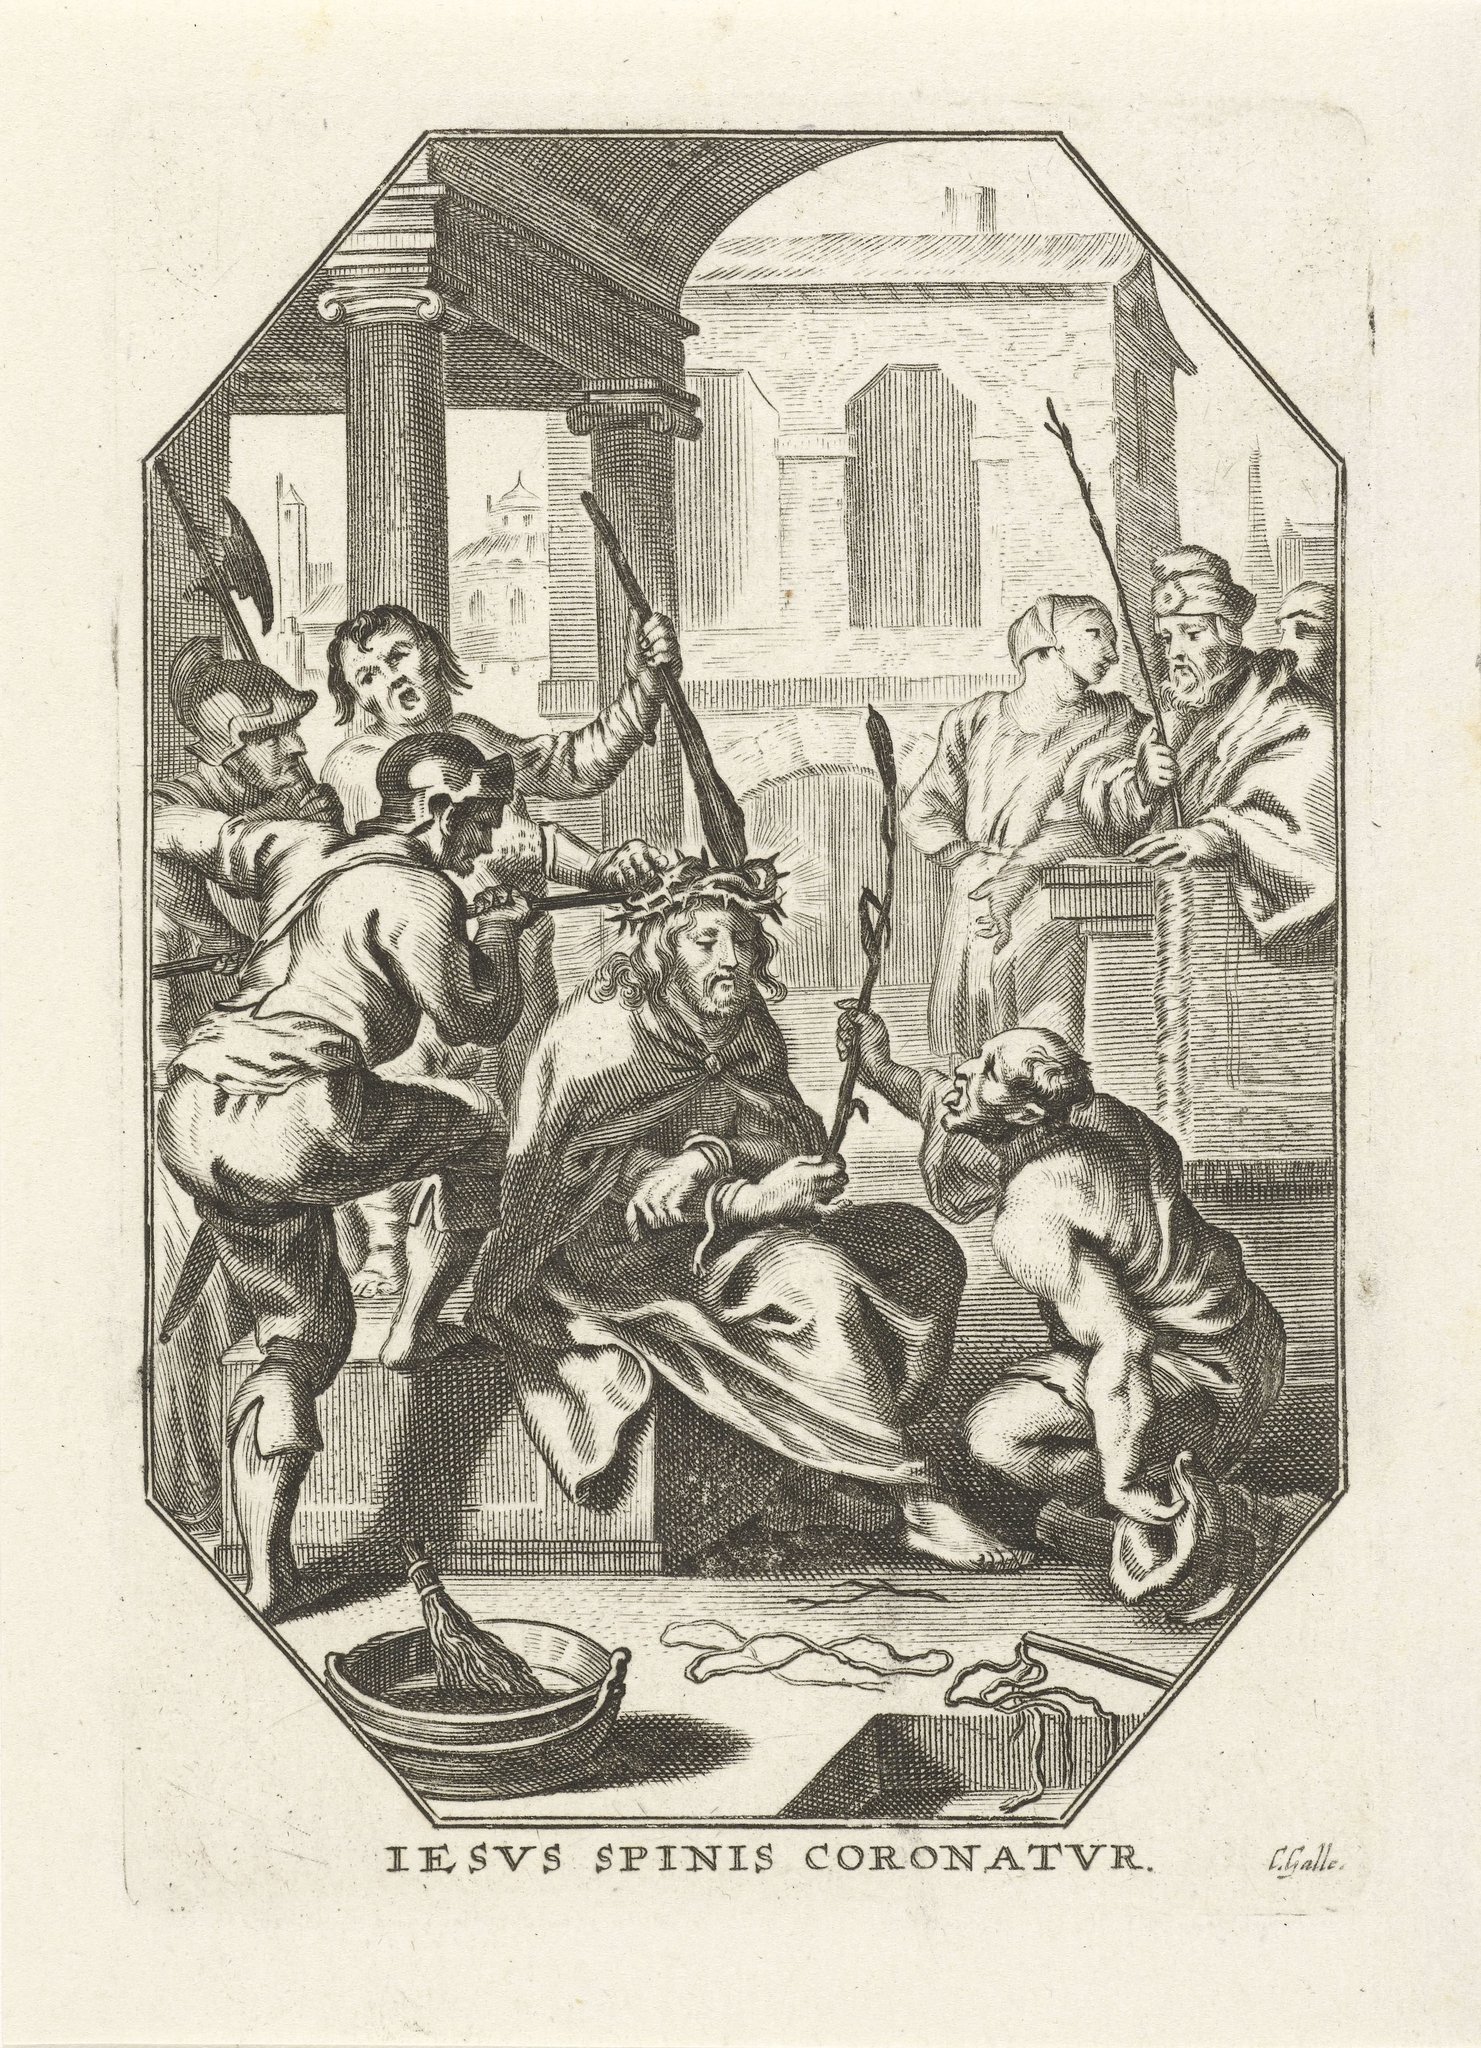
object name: print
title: Doornenkroning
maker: cornelis galle (i)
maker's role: print maker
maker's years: 1576-1650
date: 1586-1650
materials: paper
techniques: engraving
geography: southern netherlands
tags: the crowning with thorns: soldiers with sticks place a thorny crown on christ's head and give him a reed (matthew 27:27-31; mark 15:16-20; john 19:2-3)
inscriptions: collector's mark: Lugt 2228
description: Een groepje soldaten kroont Christus met de doornenkroon. Een van de soldaten zet de kroon vast op het hoofd met een knots. Zevende prent uit een serie van 13, met voorstellingen uit het lijdensverhaal van Christus.